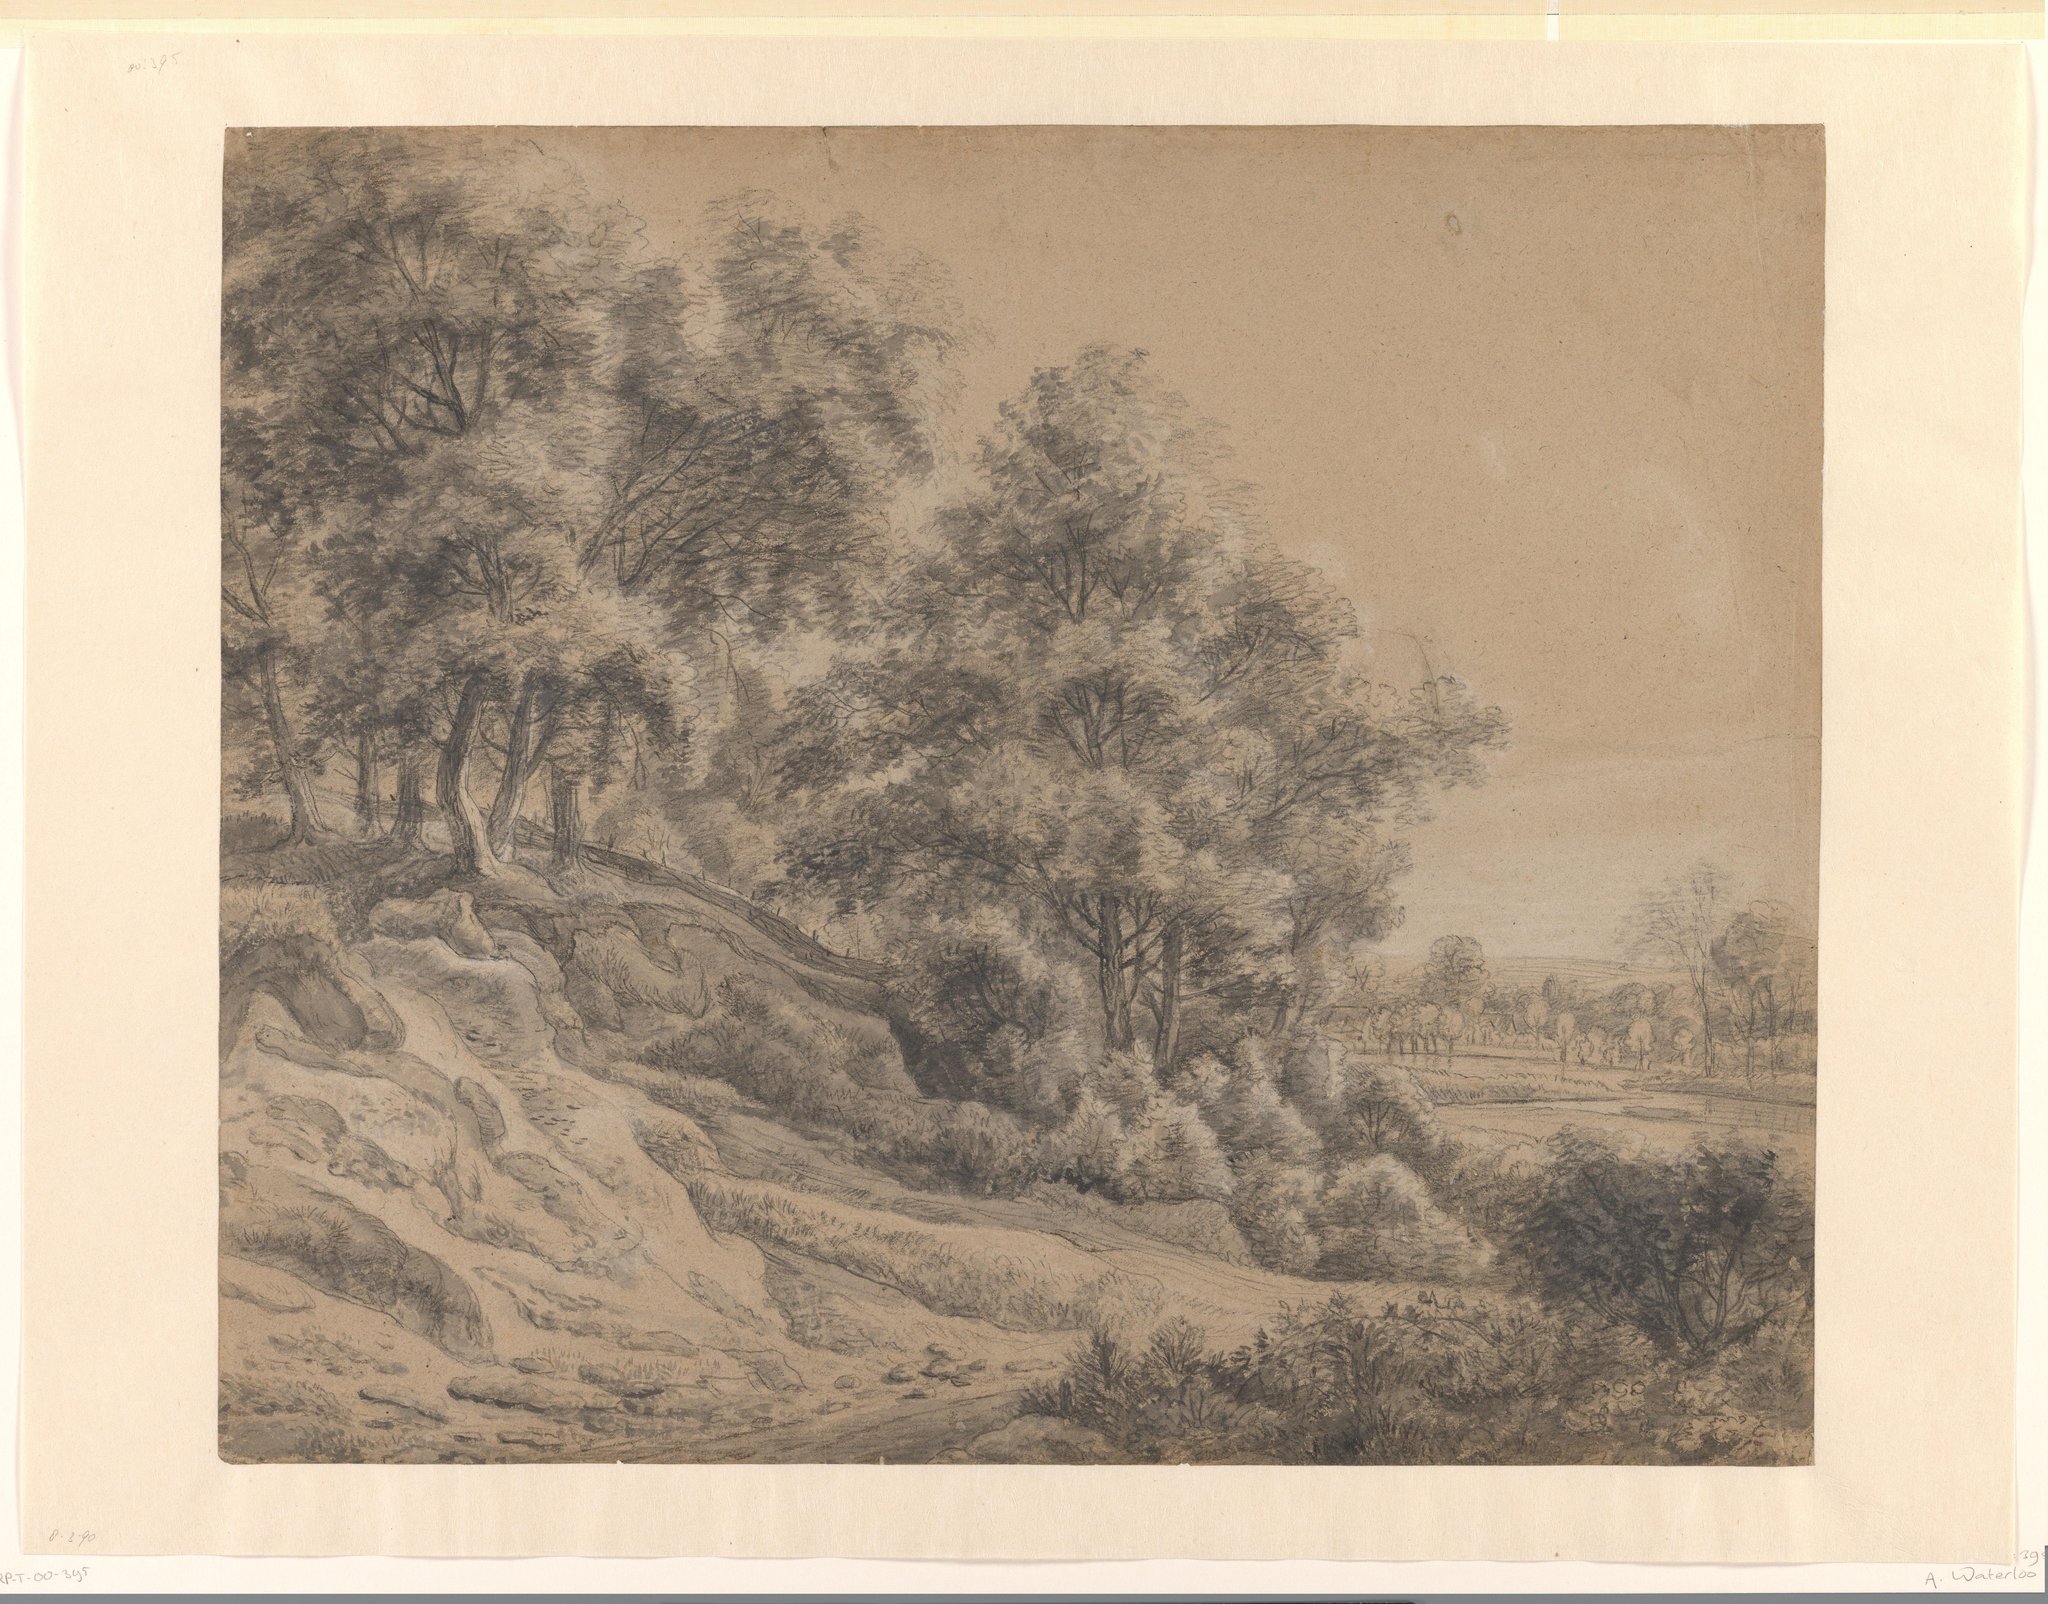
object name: drawing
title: Bomen in een heuvelachtig landschap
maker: anthonie waterloo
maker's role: draughtsman, painter, print maker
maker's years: 1609-1690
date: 1619-1690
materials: chalk, paper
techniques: brush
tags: low hill country